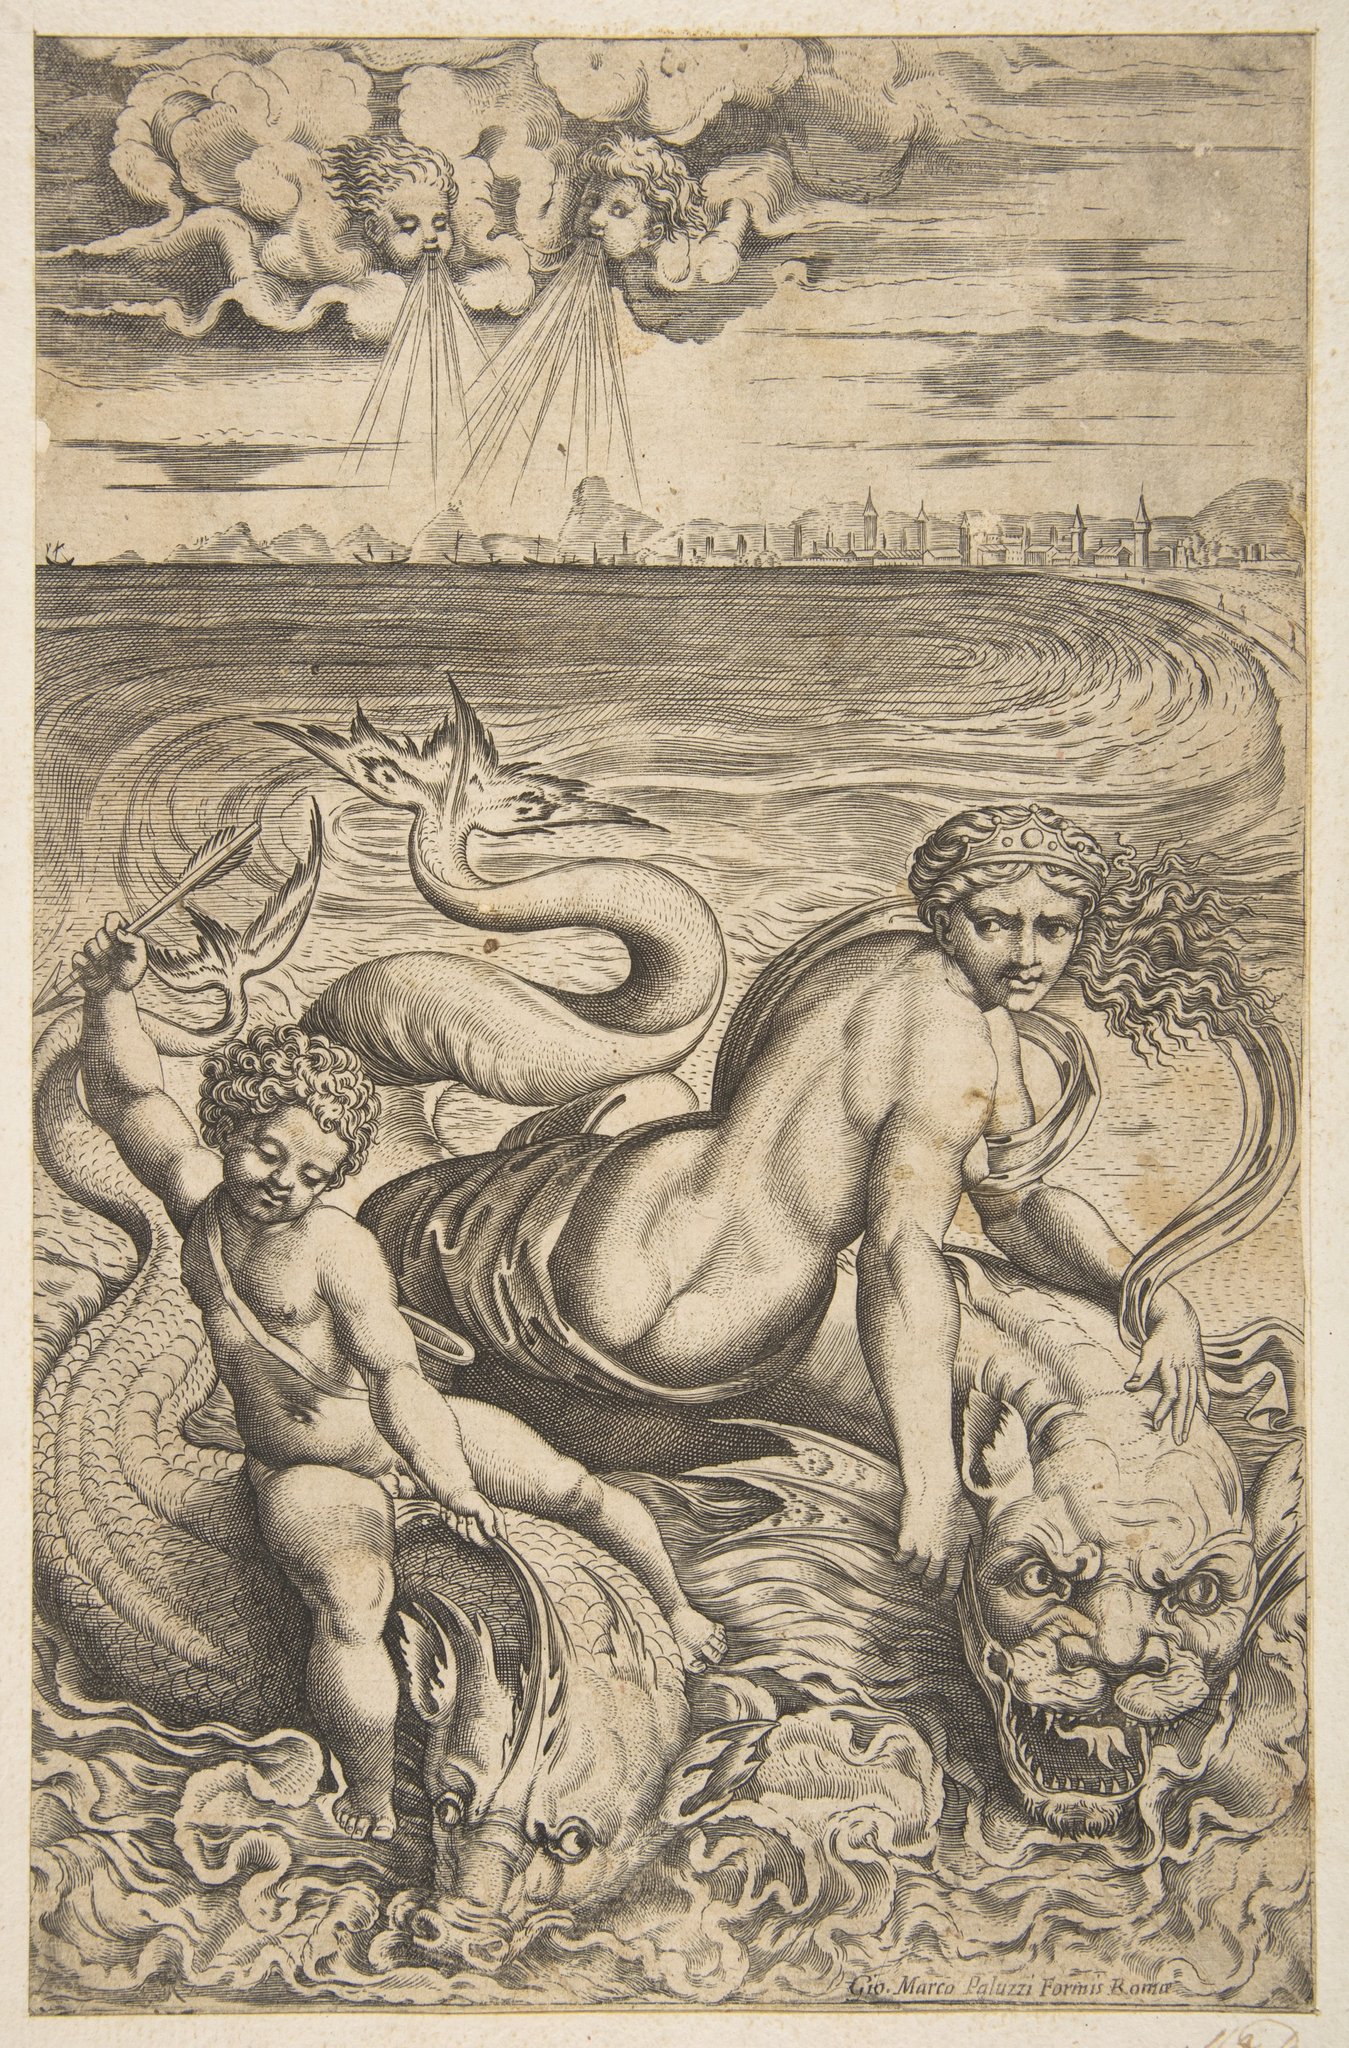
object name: print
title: Venus and Cupid riding two sea monsters, Cupid raises an arrow in his right hand, two heads representing wind in the clouds above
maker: marco dente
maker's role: artist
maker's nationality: italian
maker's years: 1515-1527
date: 1515-1527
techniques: engraving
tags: cupid,monsters,venus